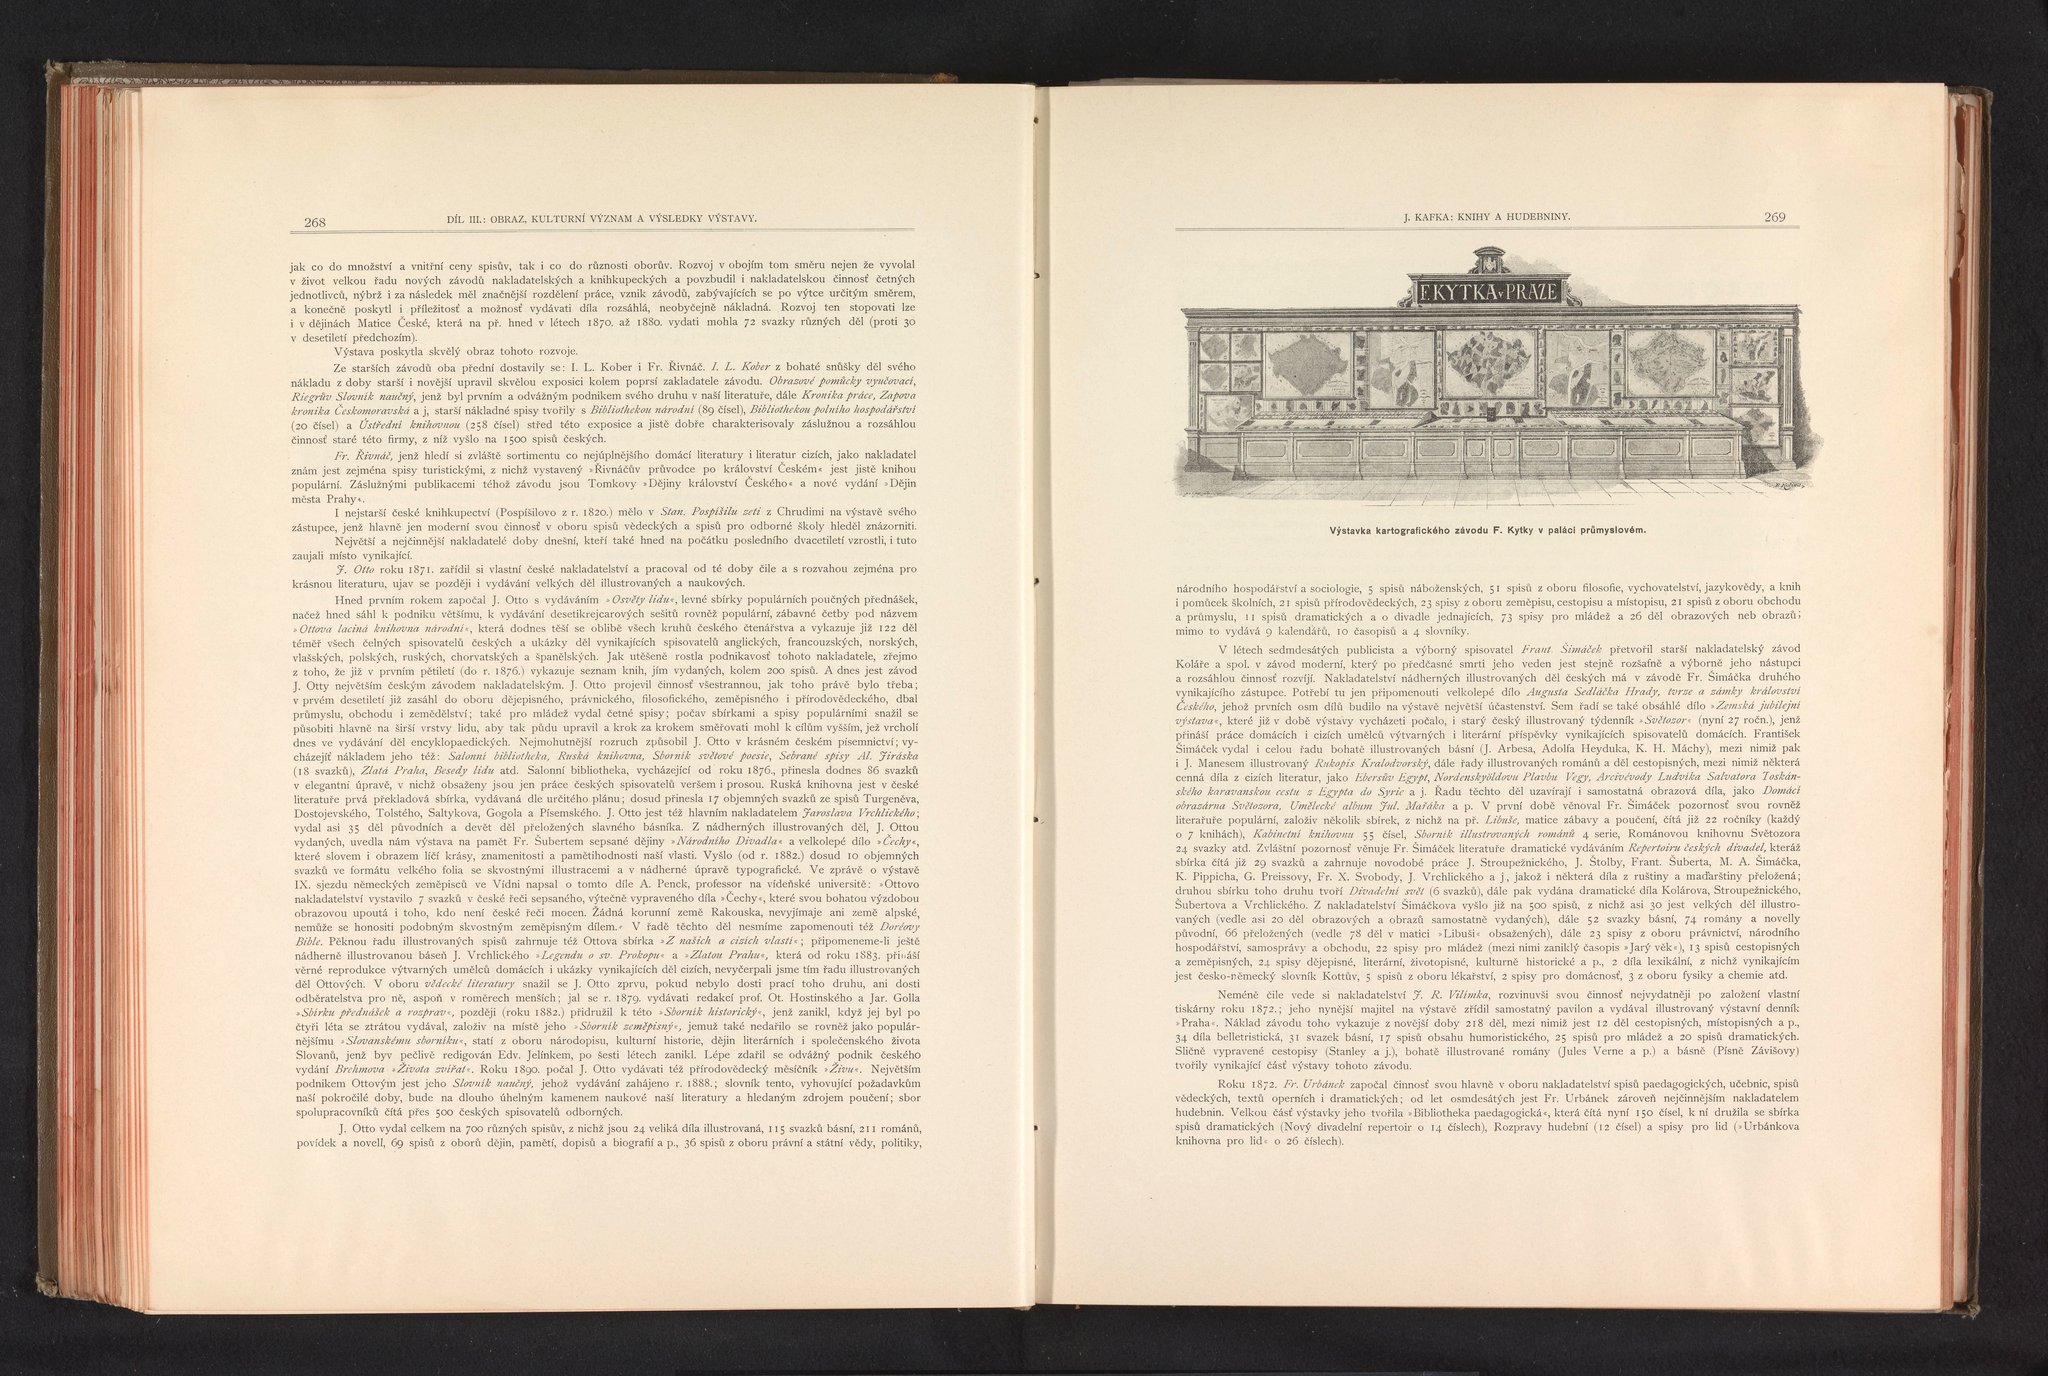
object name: page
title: Výstavka kartografického závodu F. Kytky v paláci prumyslovém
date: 1890-1895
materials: paper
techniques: autotype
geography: prague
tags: maps, atlases, temporary exhibition, 'salon'